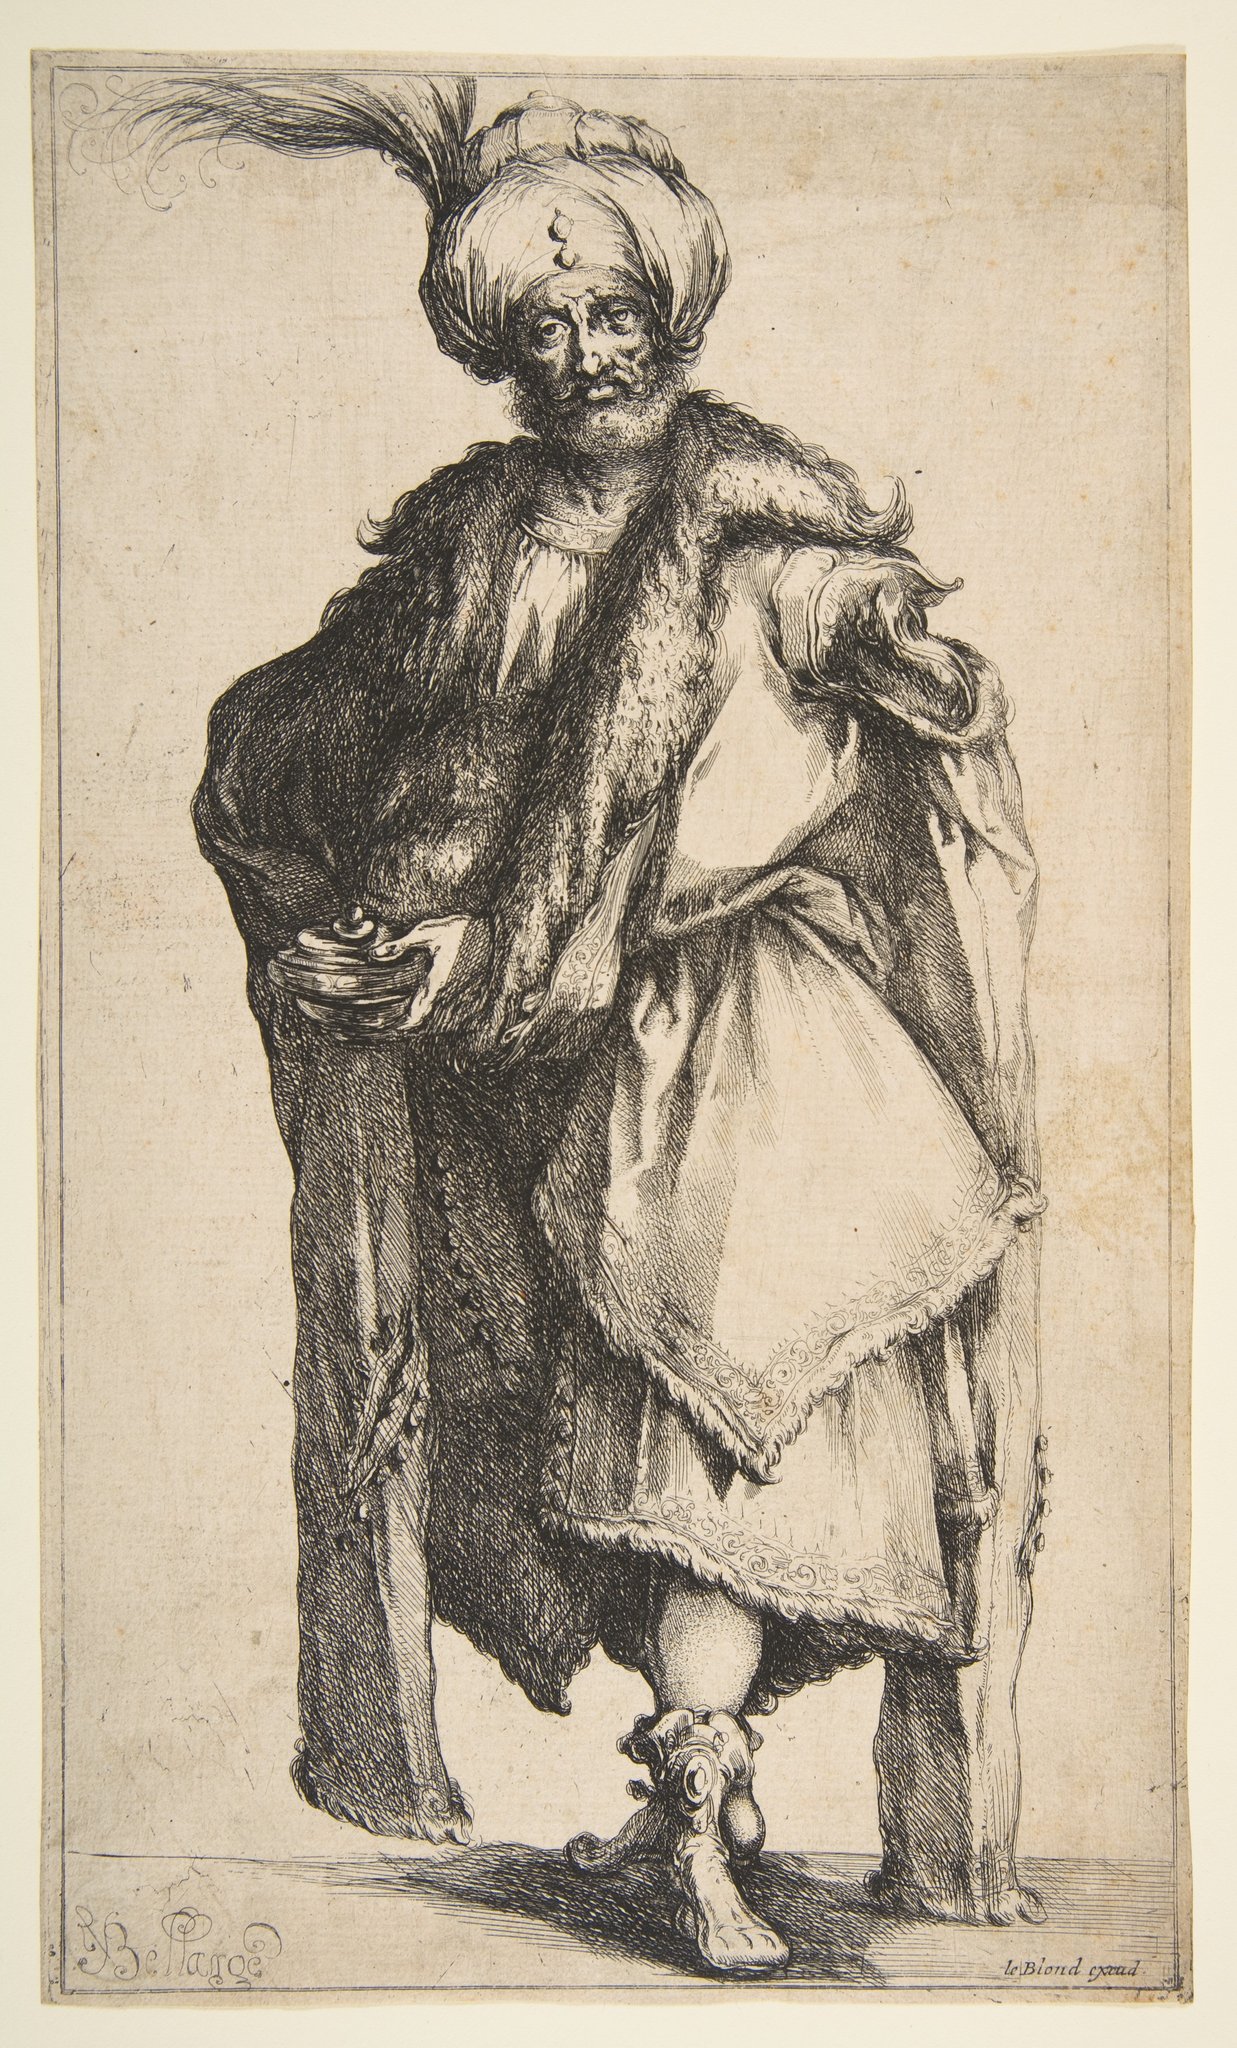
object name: print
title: Caspar, from "Three Magi"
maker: jacques bellange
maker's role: artist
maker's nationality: french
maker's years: 1575-1616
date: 1595-1616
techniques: etching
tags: men